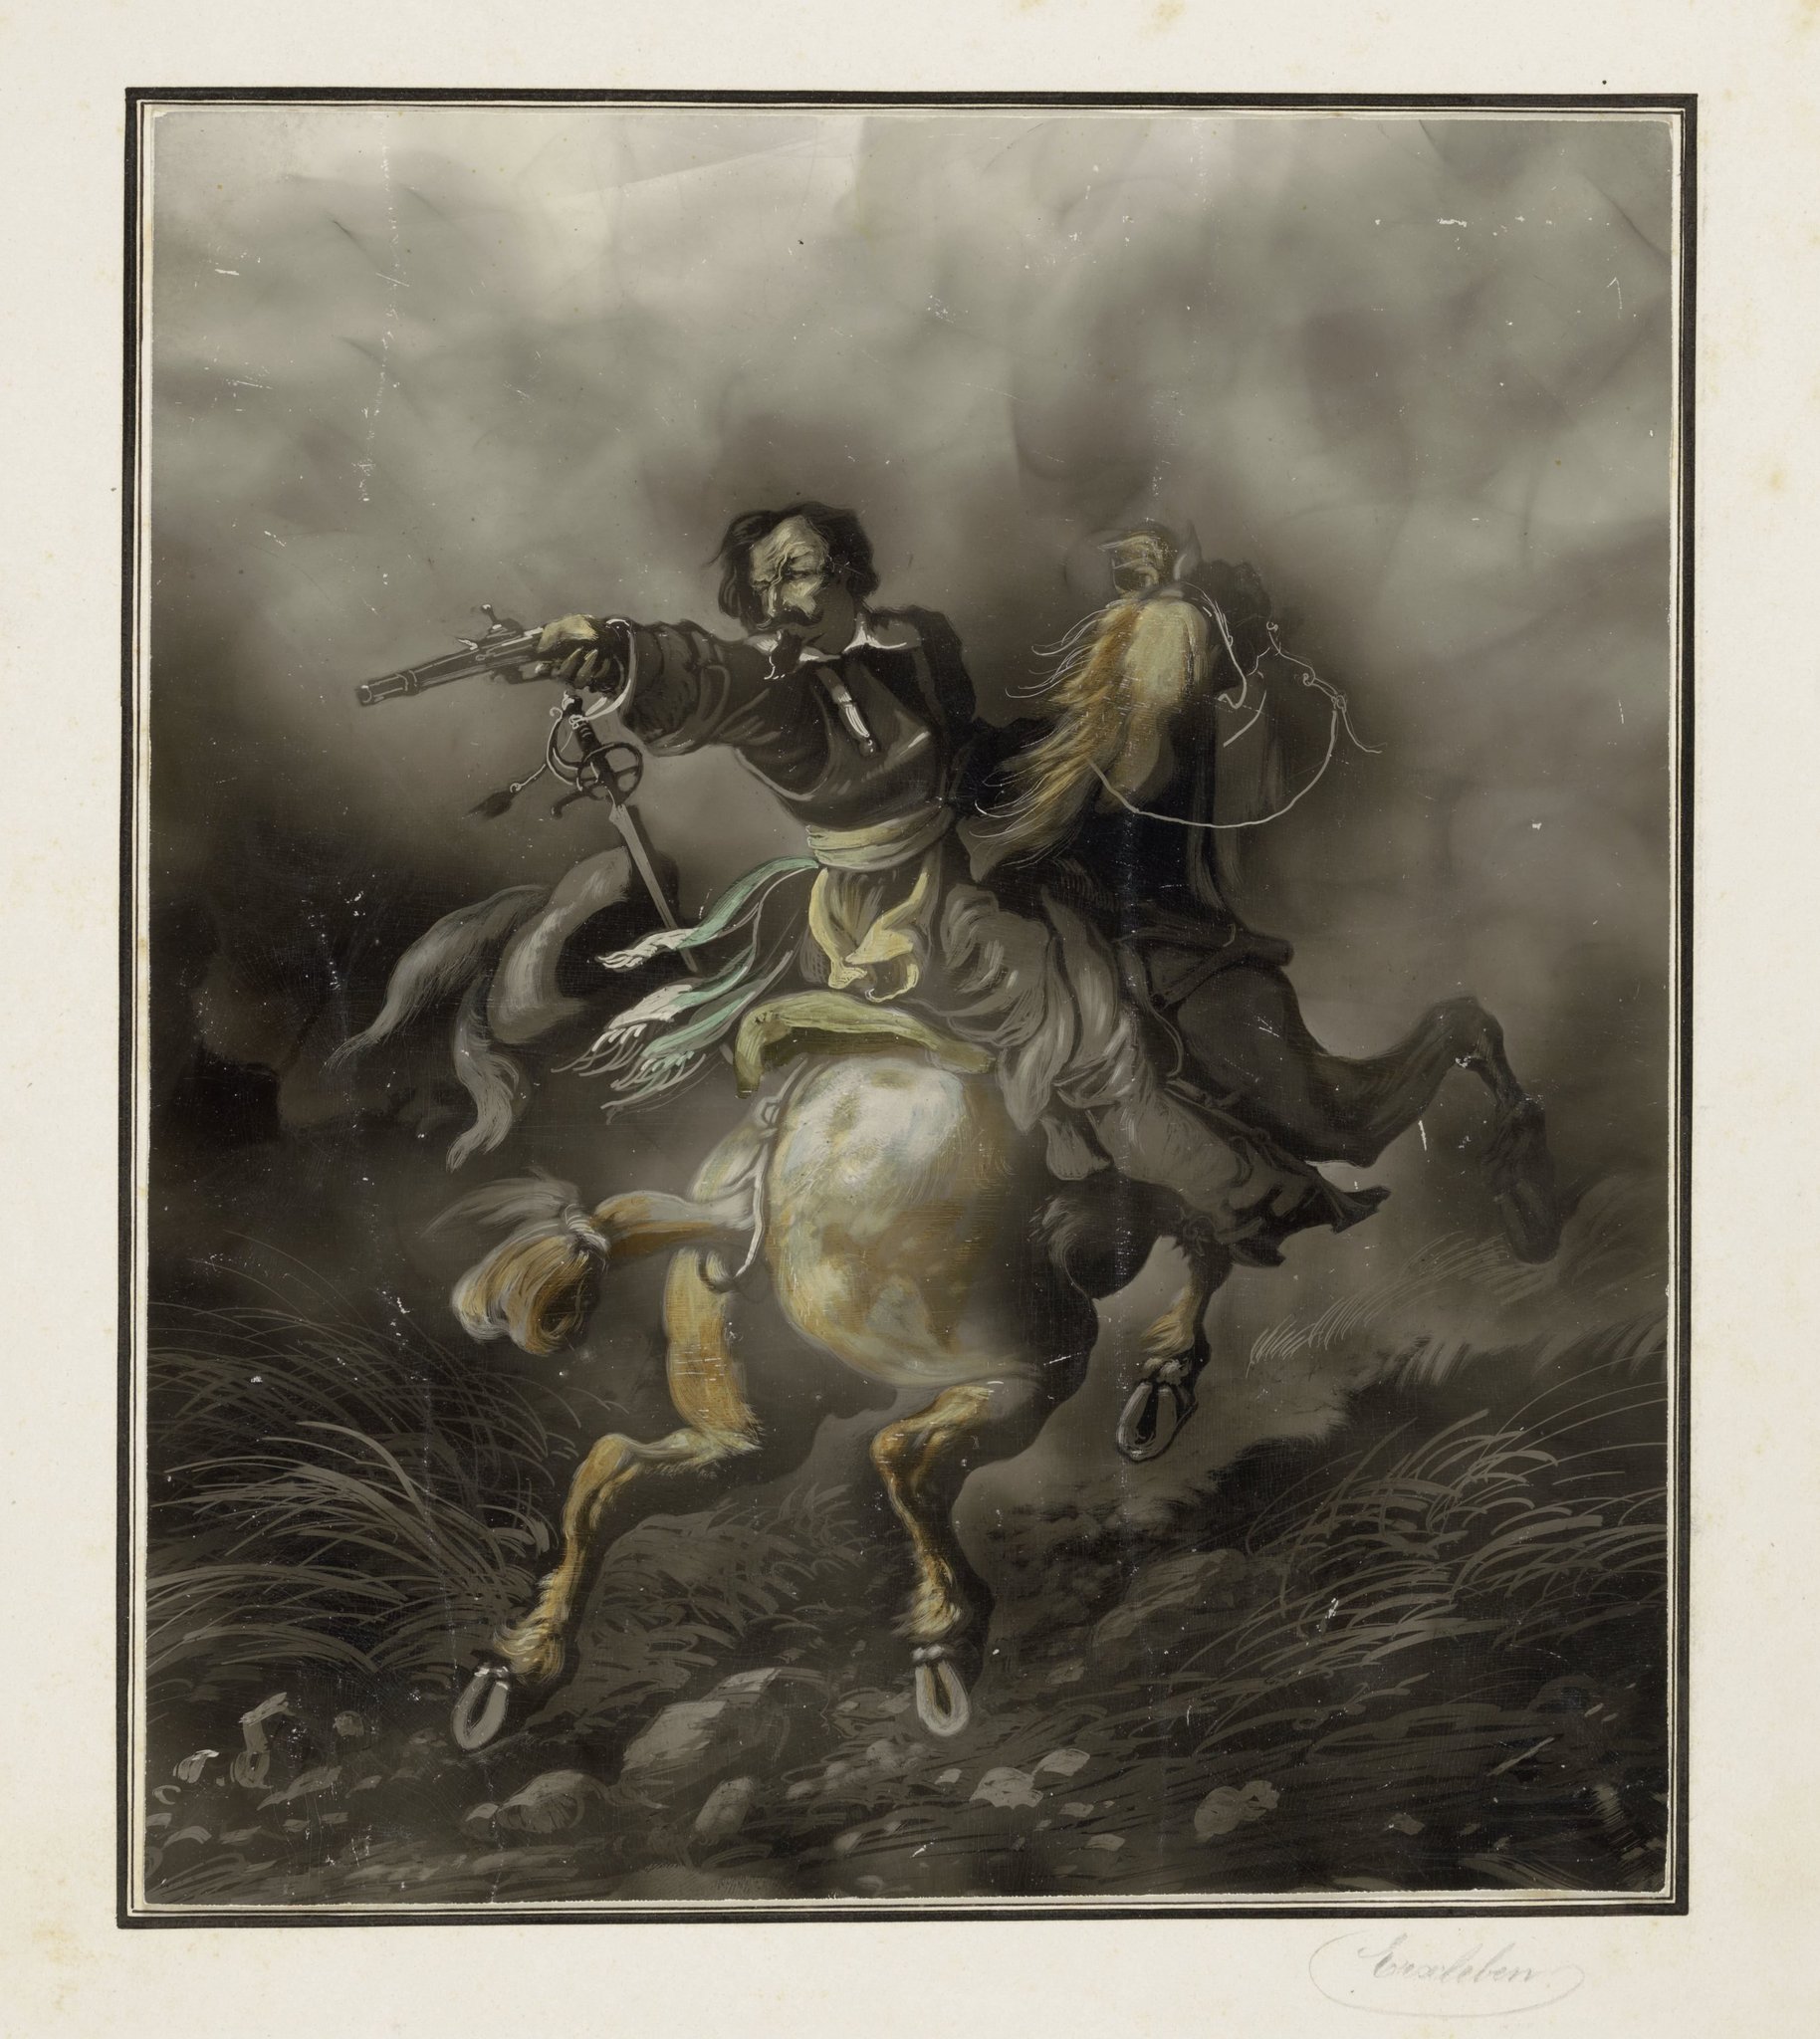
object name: photograph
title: Ruiter die zijn pistool afvuurt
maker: august erxleben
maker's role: draughtsman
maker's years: 1822-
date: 1850-1867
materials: cardboard, paint, paper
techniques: brush, smokepicture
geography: germany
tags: riding a horse, ass, or mule; rider, horseman, firearms, germany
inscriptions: signature: ‘Erxleben’, inscription: ‘Rauchbild,/ gefirnisst/ 114654’, inscription: ‘DM 600,-’, inscription: ‘August Erxleben/ tätig um 1859-67 in München, danach Amerika/ Galoppierender im Angriff. Überarbeitetes Rauchbild. (...) Alt montiert.’